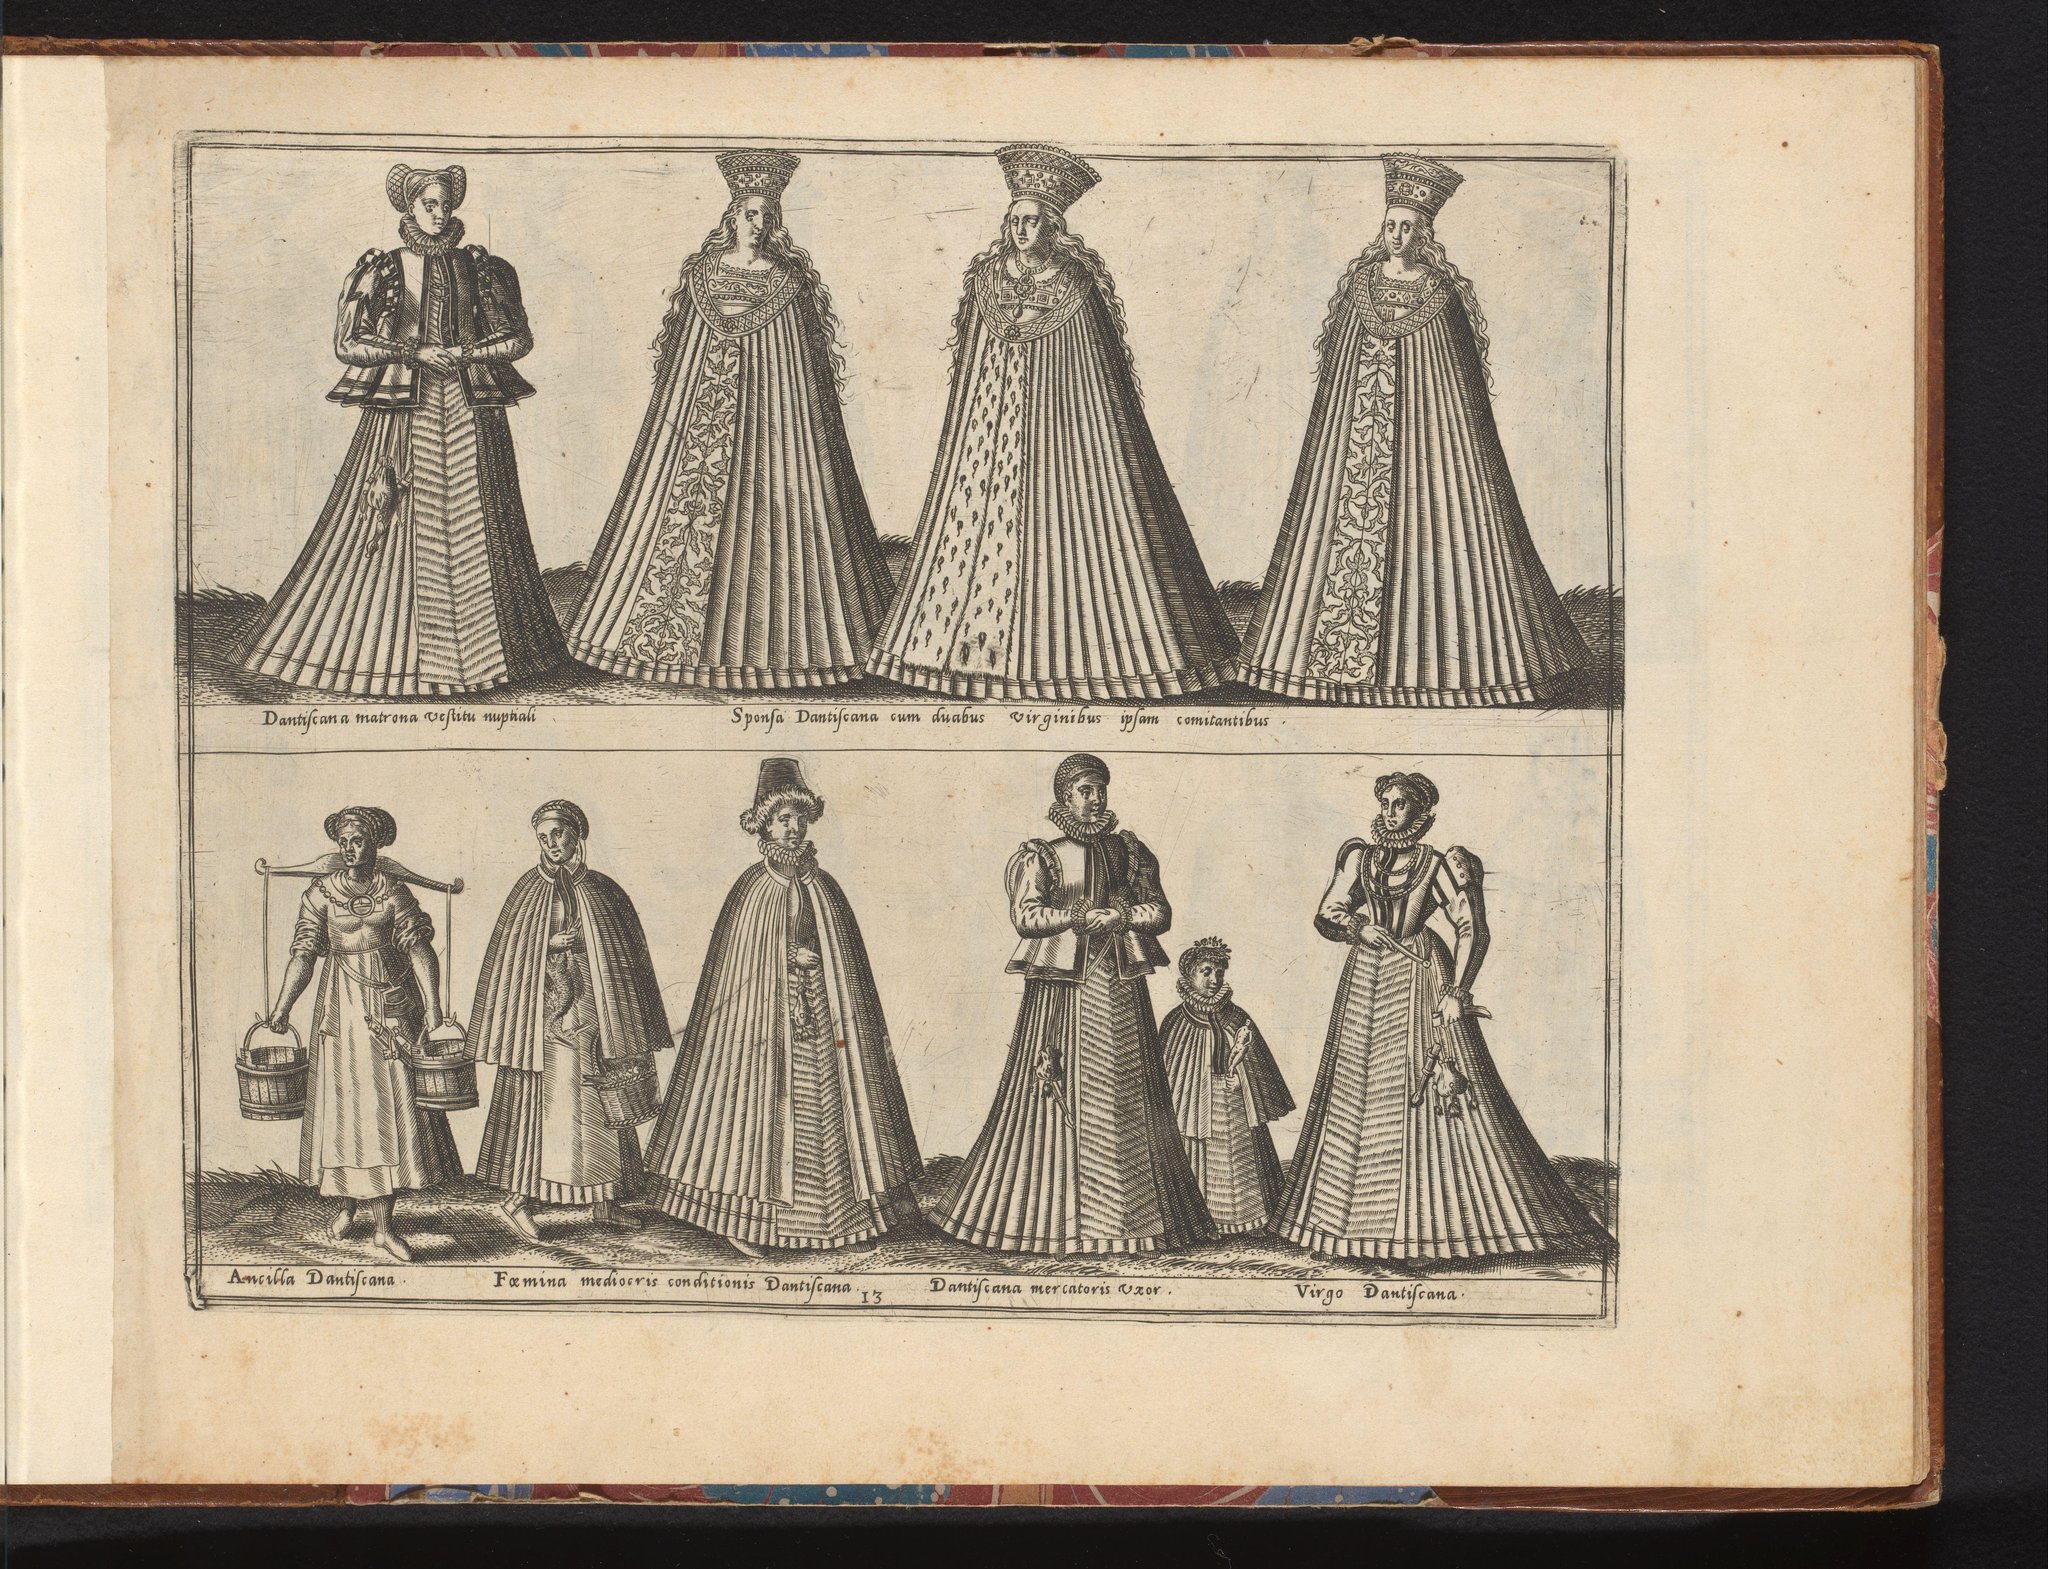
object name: album leaf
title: Negen vrouwen uit verschillende standen, gekleed volgens de mode van ca. 1580 in Danzig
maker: abraham de bruyn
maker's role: print maker, publisher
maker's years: 1540-1587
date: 1581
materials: paper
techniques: engraving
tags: europeans: germans (+ women), division into classes (~ society), europeans: germans (+ costume), milkmaid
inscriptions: number: ‘13’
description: Twee rijen onder elkaar. Op de onderste rij een melkmeid (links) en een vrouw met kind. Prent uit het boek 'Omnium pene Europae, Asiae, Aphricae atque Americae gentium habitus...', 1581. De prent maakt deel uit van een album.